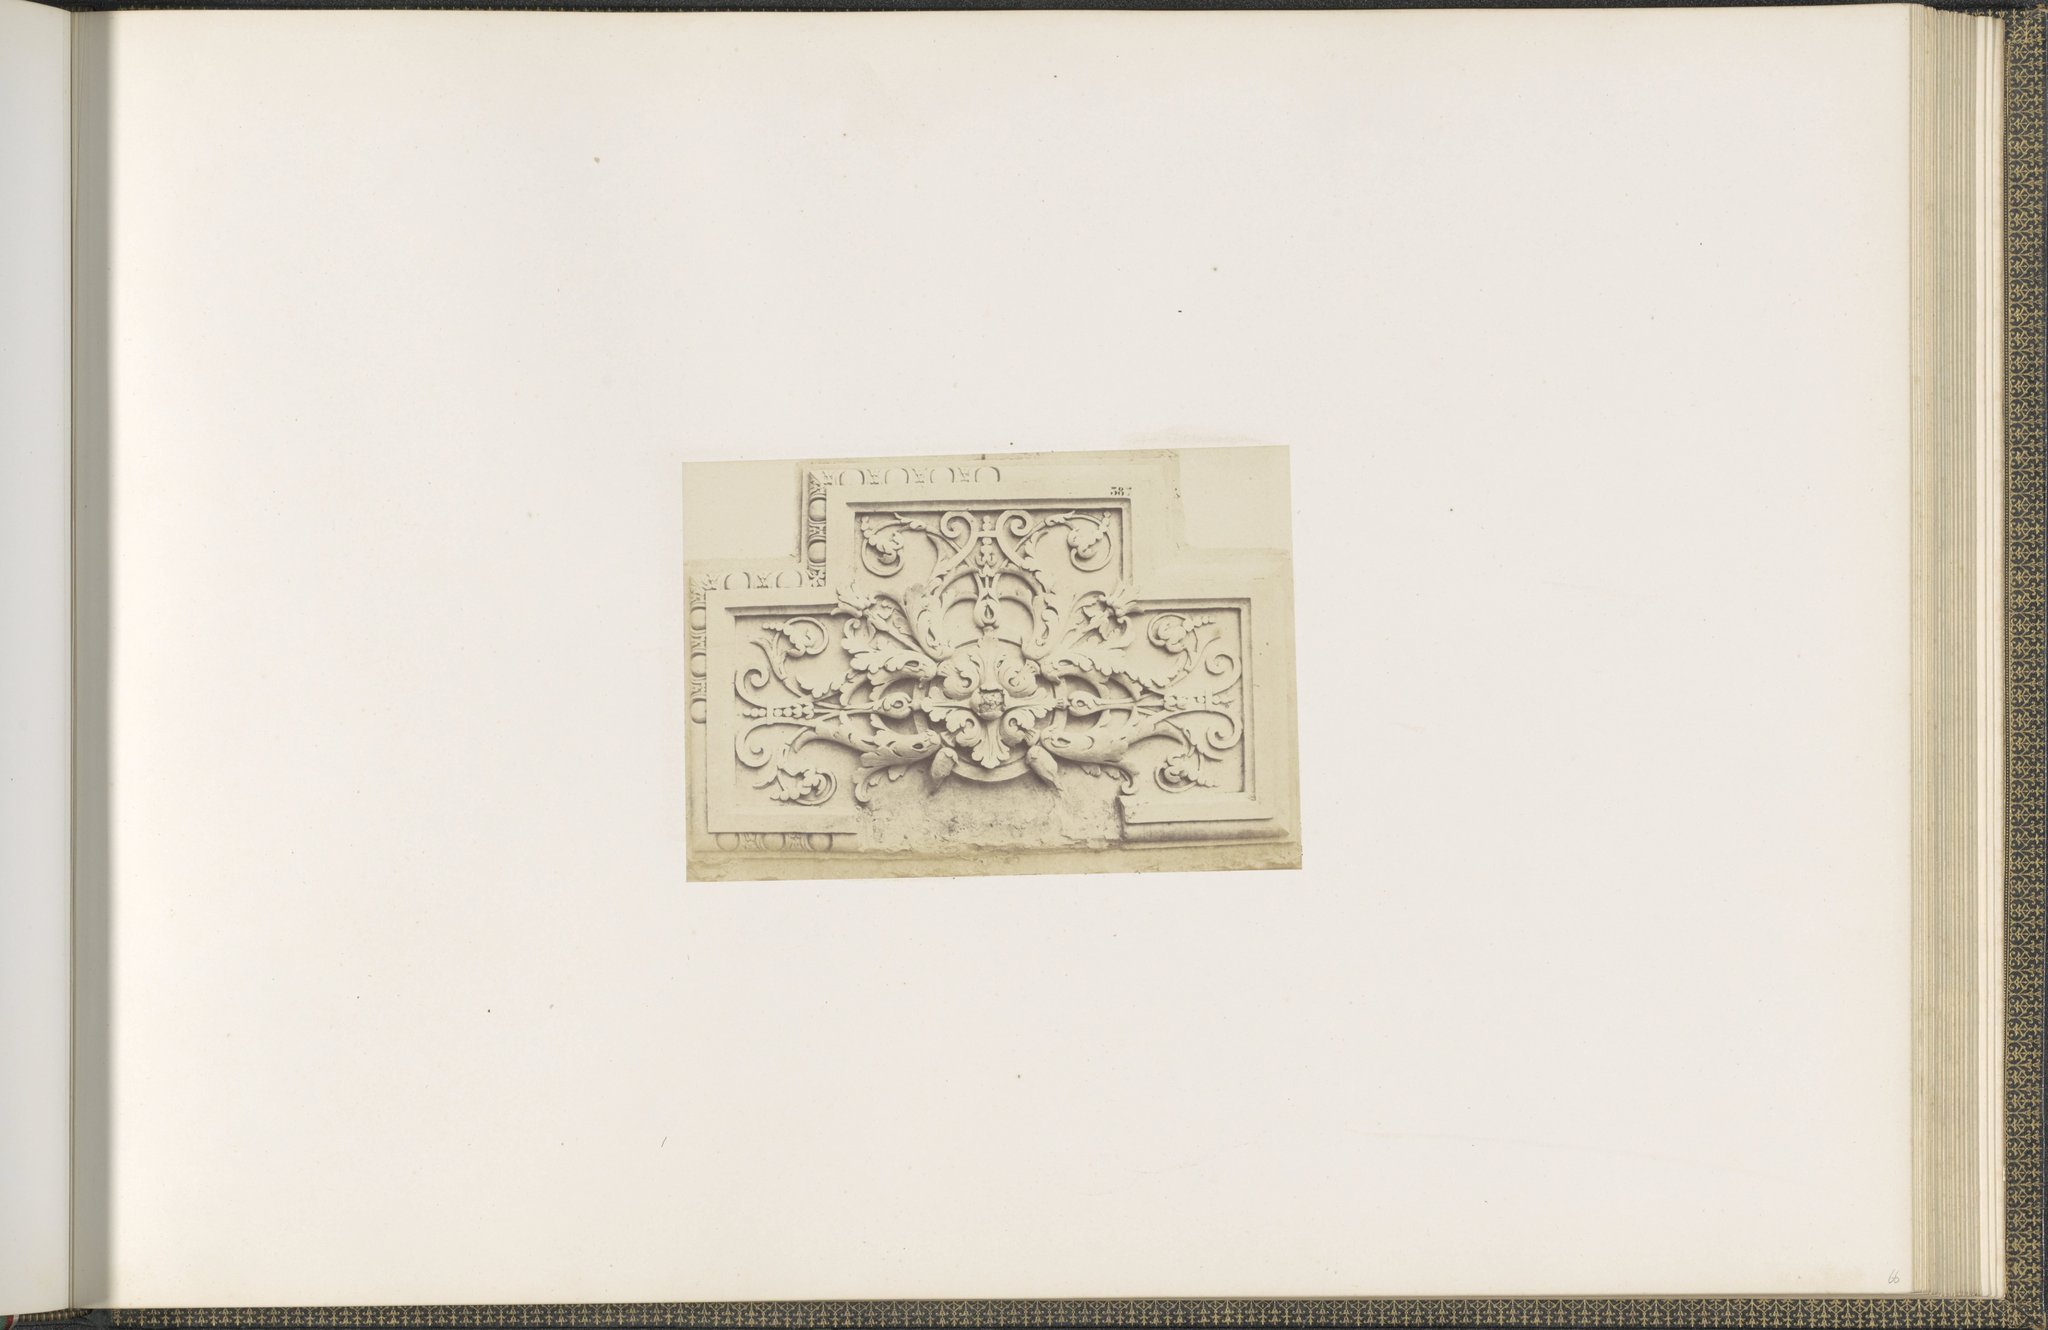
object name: photograph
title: Gipsmodel voor versiering van het Palais du Louvre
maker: édouard denis baldus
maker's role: fotograaf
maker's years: 1813-1889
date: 1855-1857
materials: paper, photographic support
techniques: salted paper print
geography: paris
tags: permanent exhibition, museum, ornamenting, decorating ~ applied arts, paris, tuileries palace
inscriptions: number: ‘387’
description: Onderdeel van Réunion des Tuileries au Louvre 1852-1857, album 4.